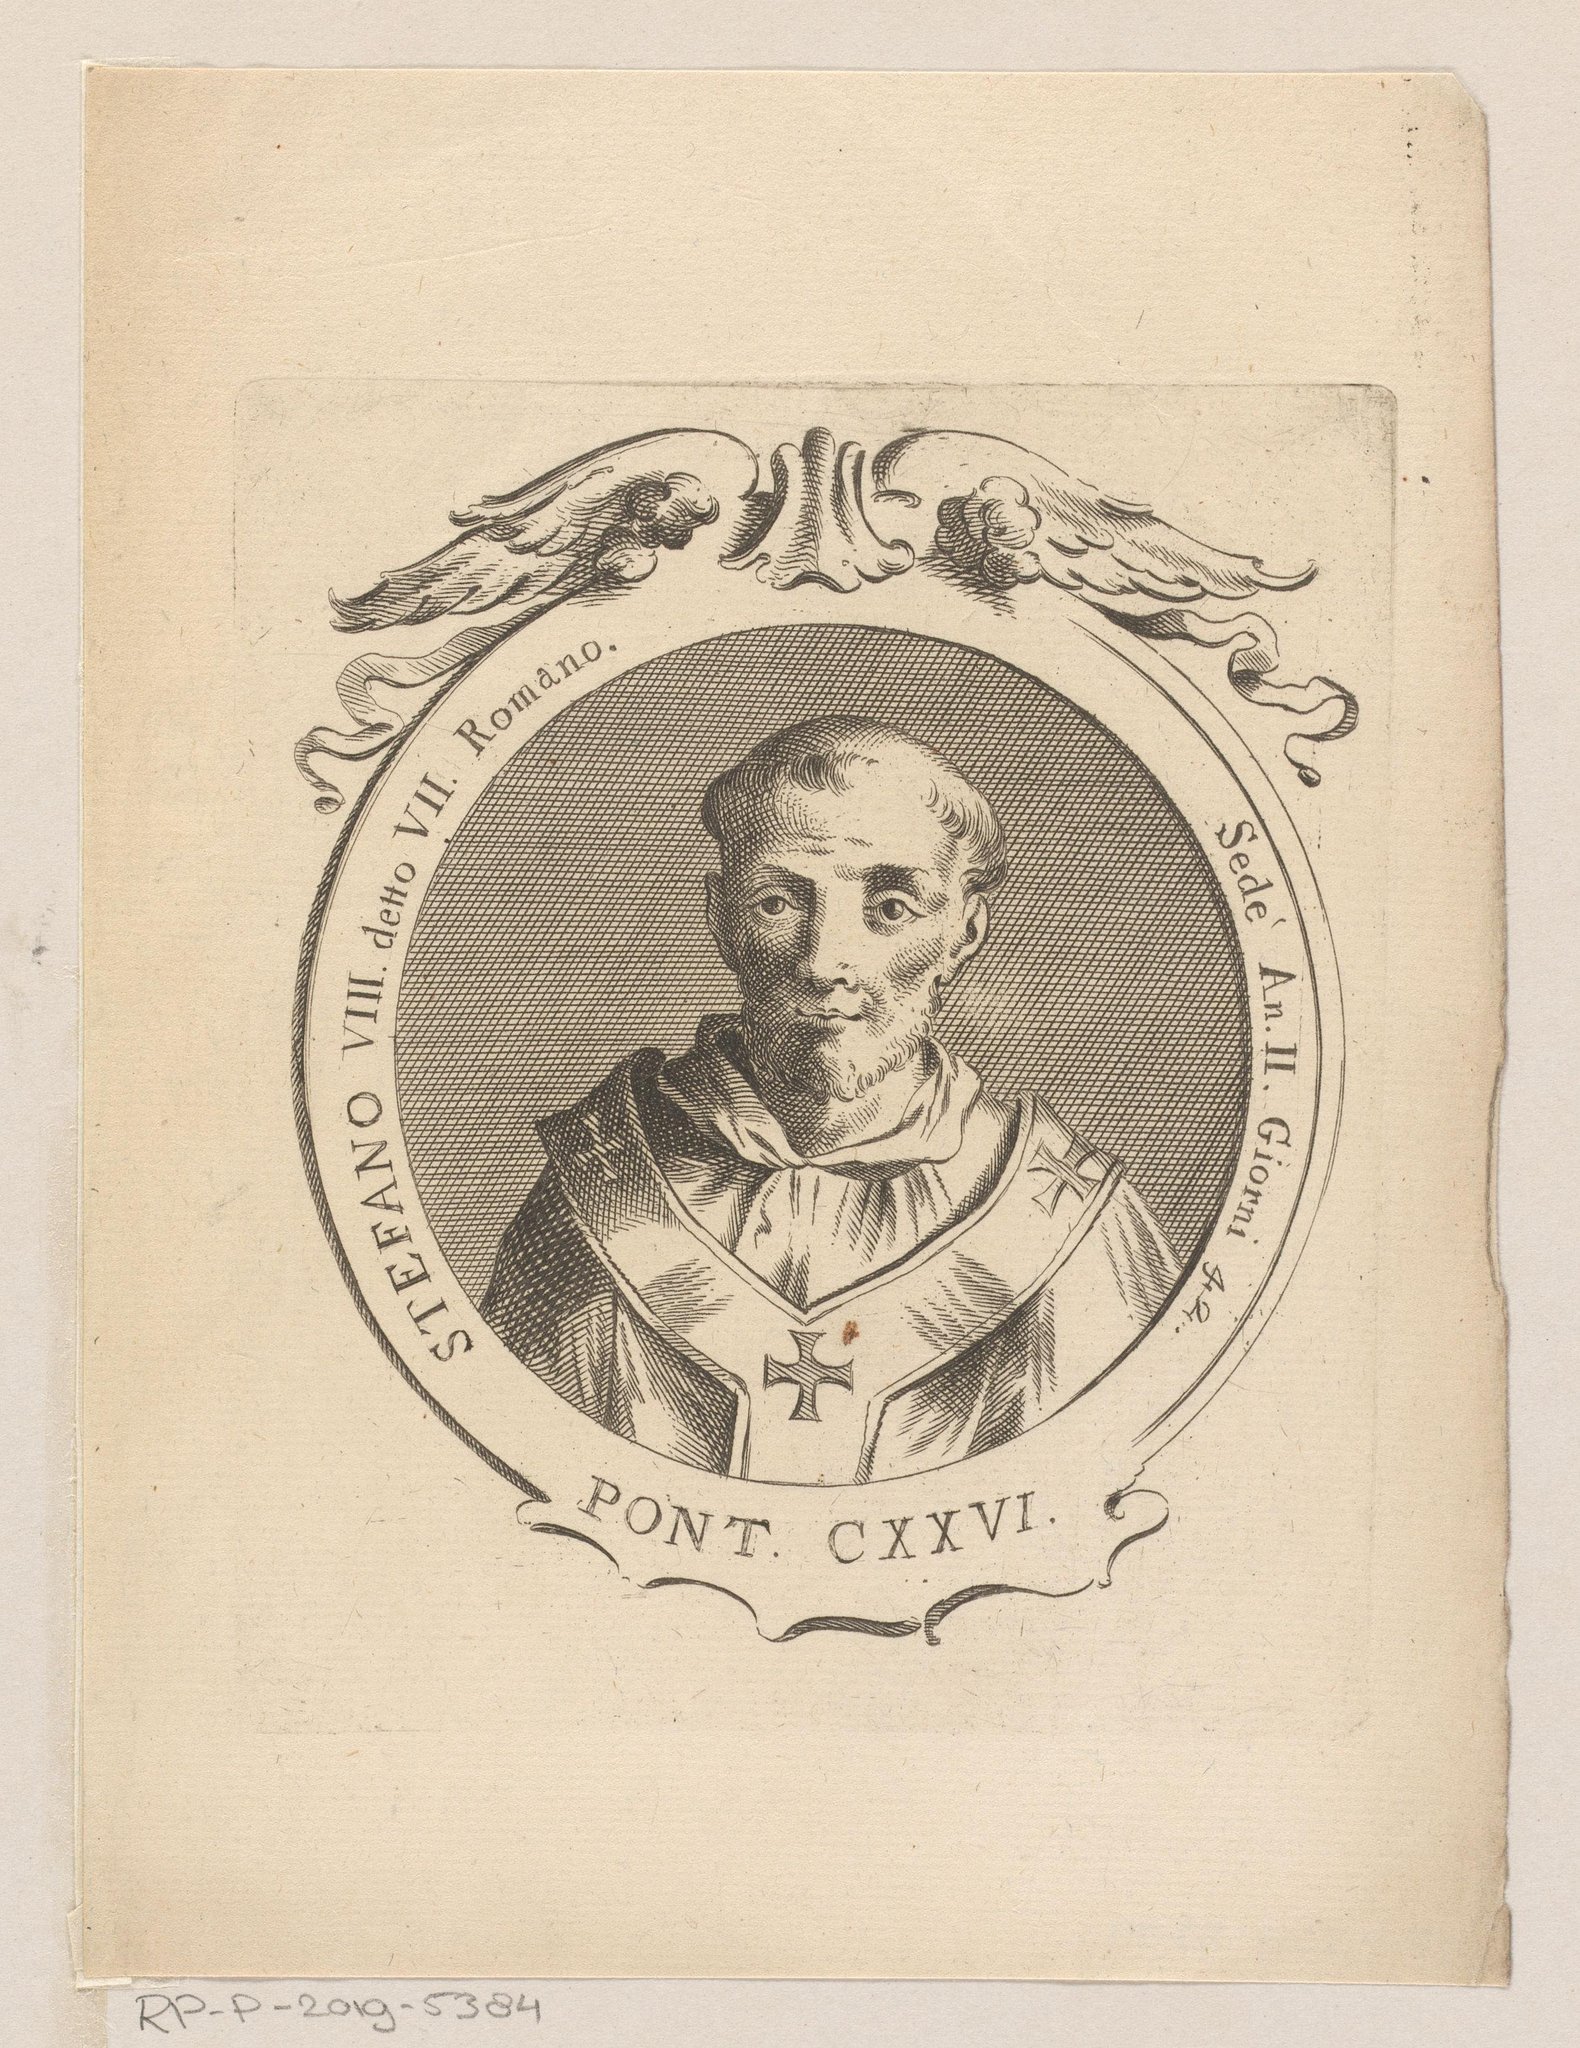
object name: print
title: Portret van paus Stefanus VII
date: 1775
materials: paper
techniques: engraving, etching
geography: venice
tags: rome, historical persons, pope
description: Prent uit: Effigies Romanorum pontificum a S. Petro ad Pium VI. feliciter regnantem (...). 2 dln. Venetië en Bassano del Grappa: Giuseppe Remondini, 1775.